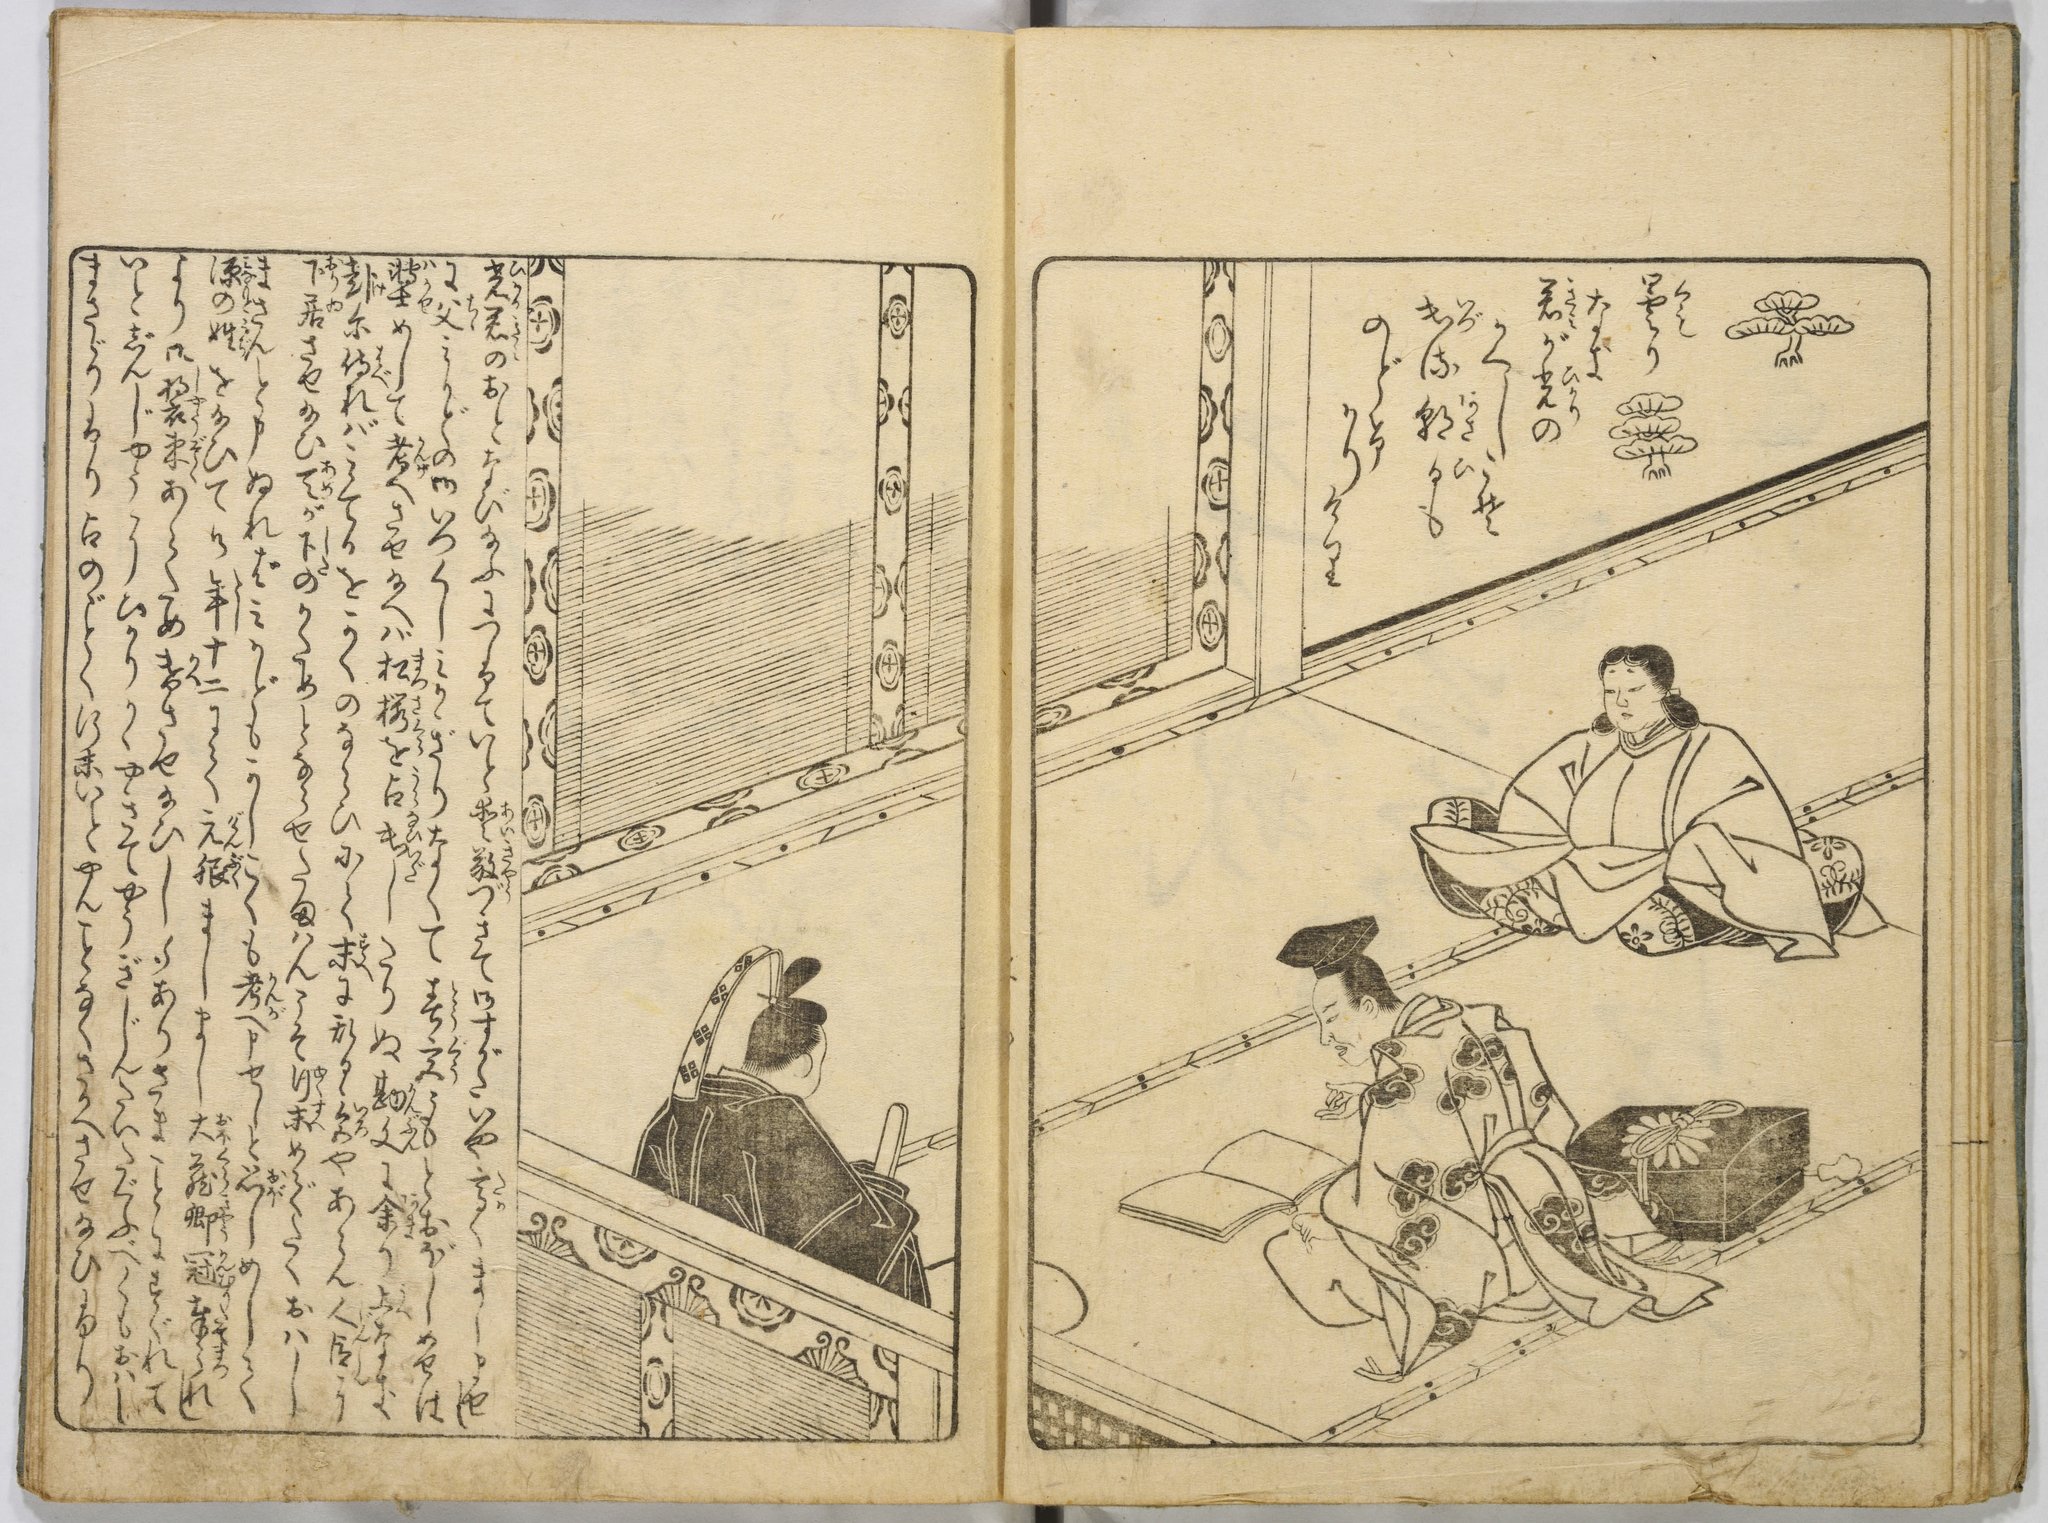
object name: illustrated book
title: Ehon Genji Monogatari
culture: japanese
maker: terai shosen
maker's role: artist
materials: ink, paper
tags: men,women,reading